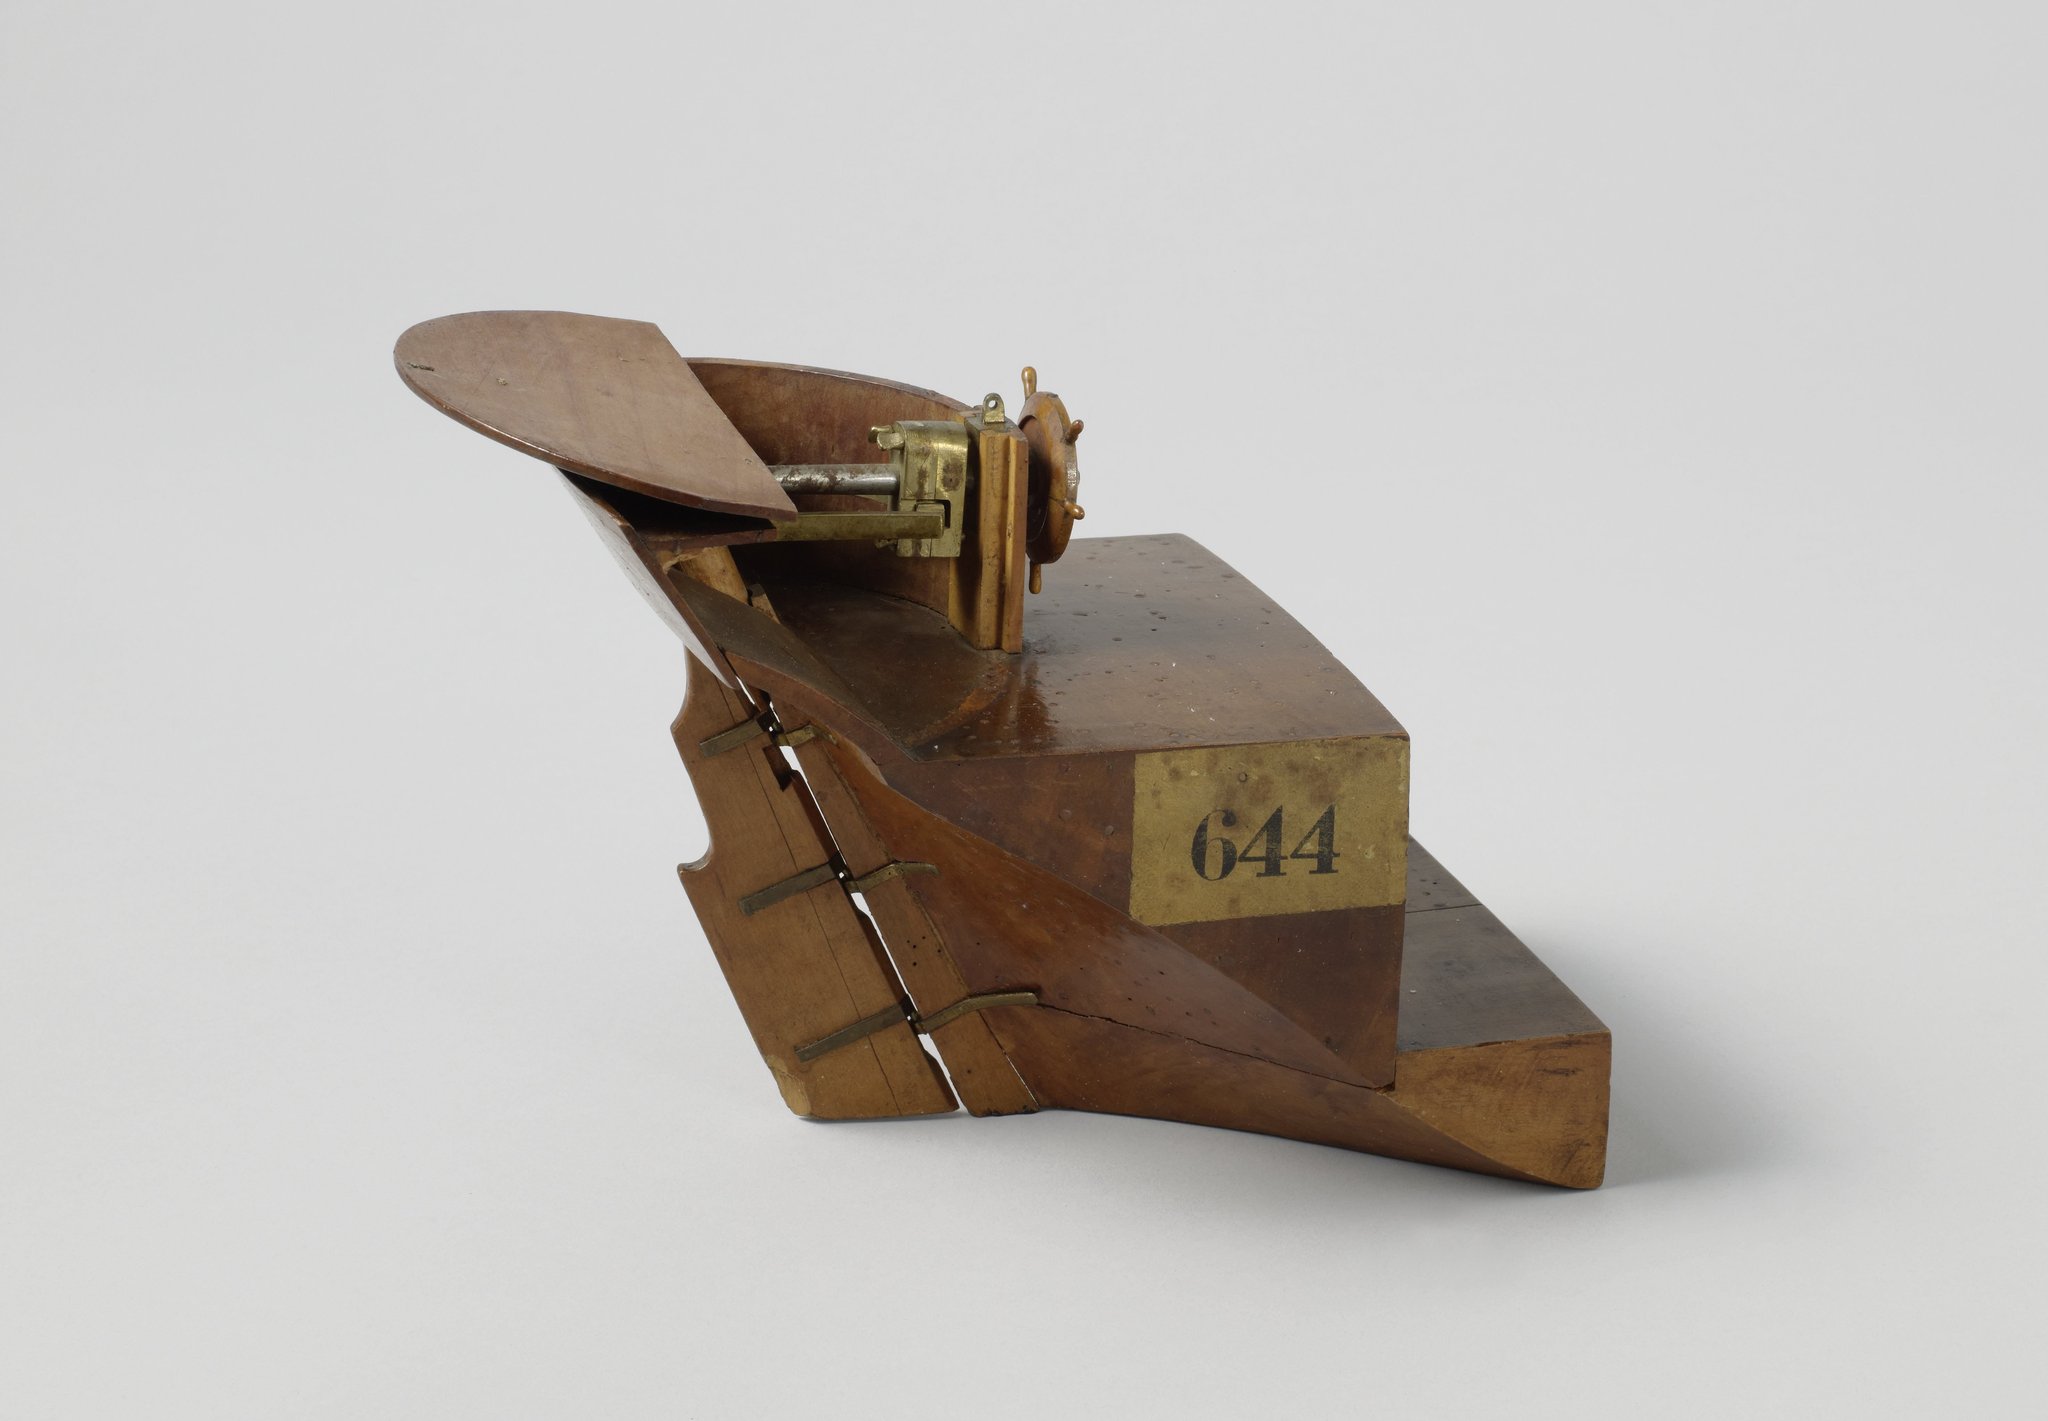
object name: demonstration model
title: Model of Steering Gear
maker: Anonymous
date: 1820-1858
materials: brass, wood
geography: netherlands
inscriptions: label: ‘644’ former inventory label